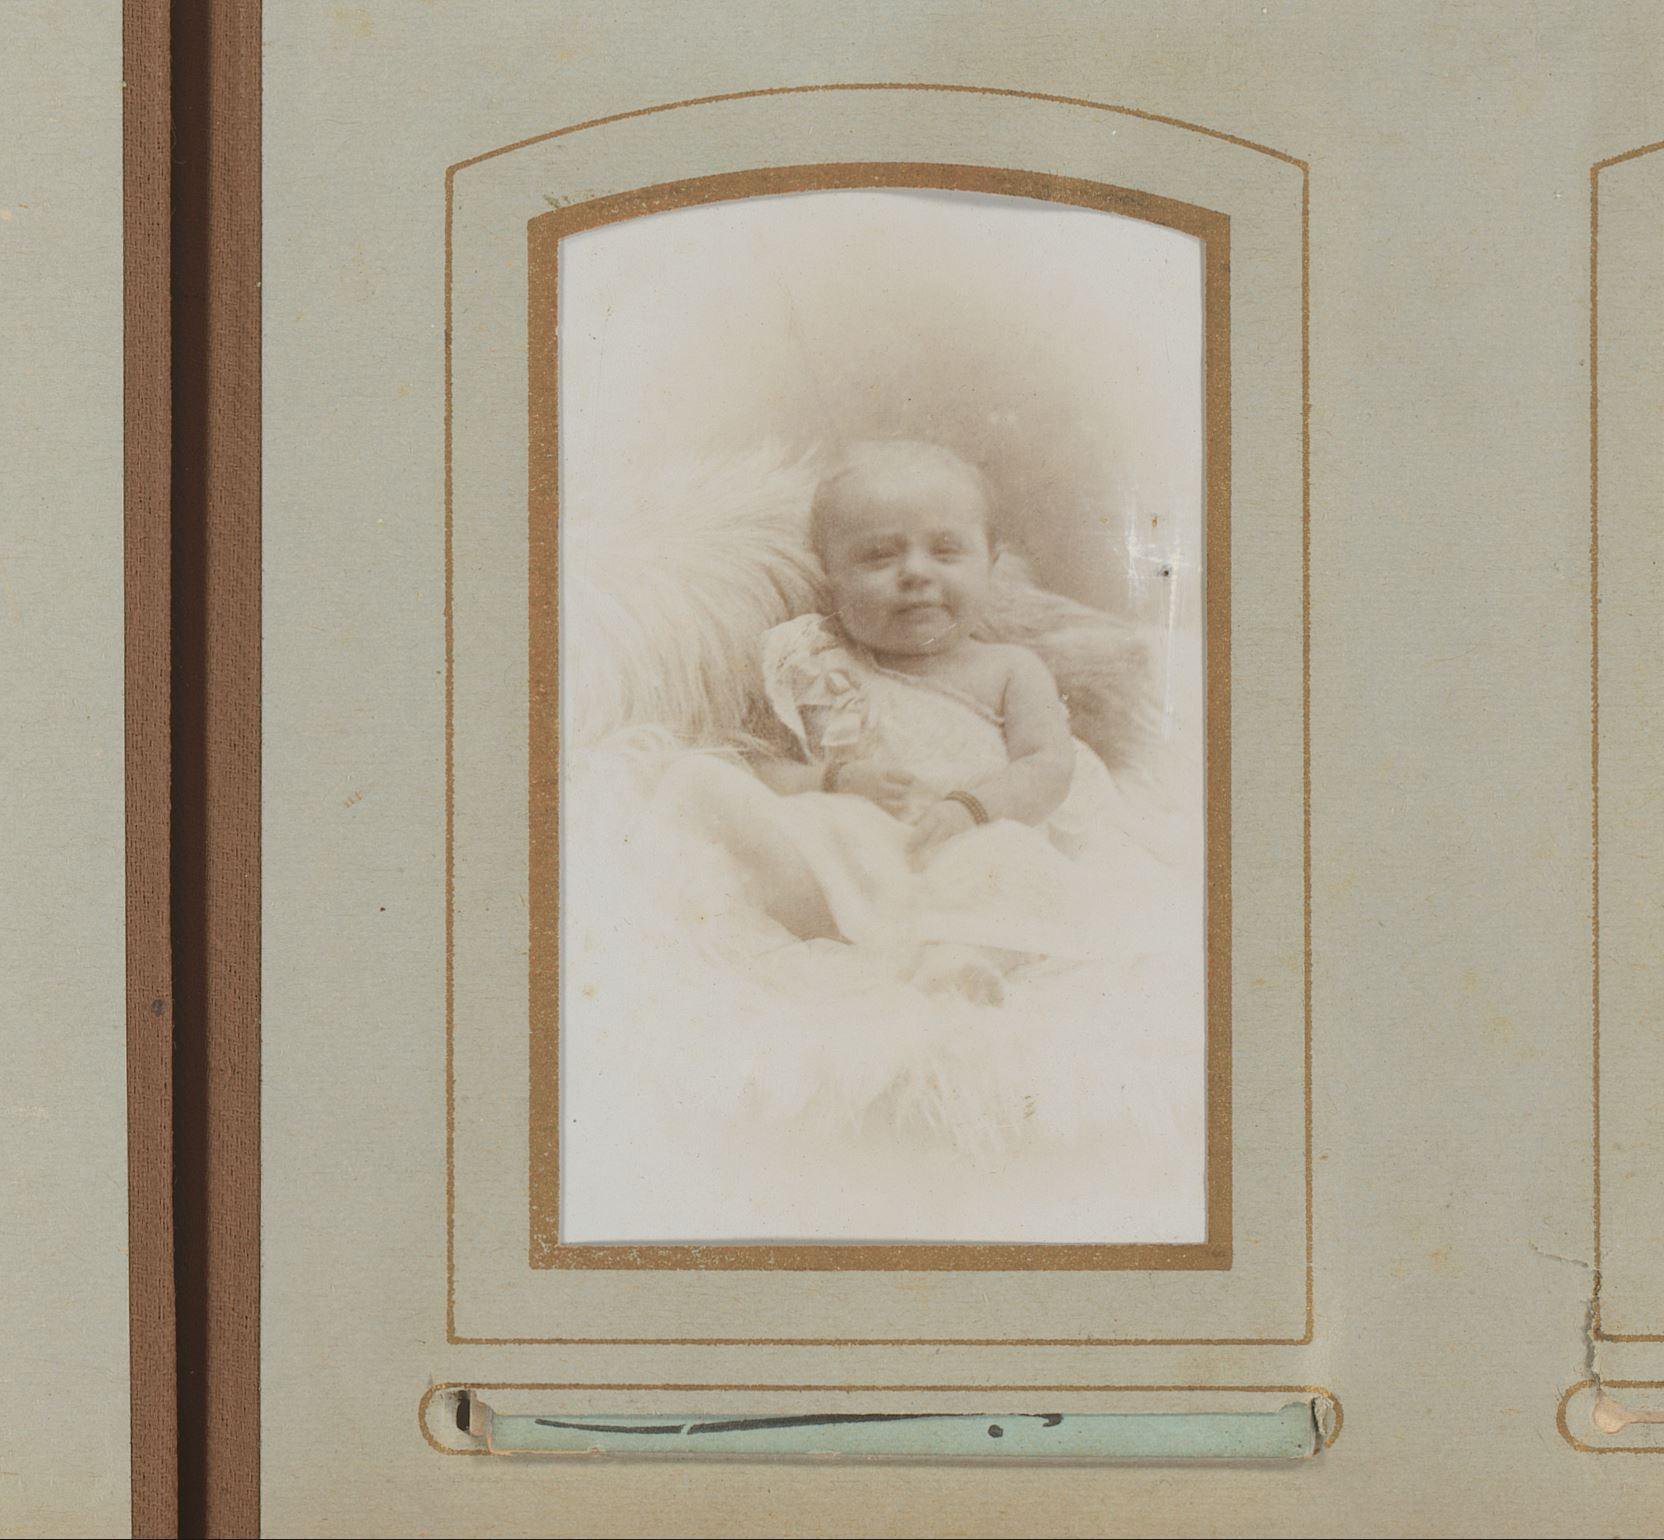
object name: photograph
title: Portret van een zittende baby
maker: stephanus wilhelmus eskes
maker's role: fotograaf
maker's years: 1869-1921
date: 1895-1921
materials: cardboard, photographic support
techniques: collodion silver print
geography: gorinchem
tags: child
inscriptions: inscription: ‘S.W. Eskes/ Fotograaf/ Gorinchem/ Kalkhaven 291’